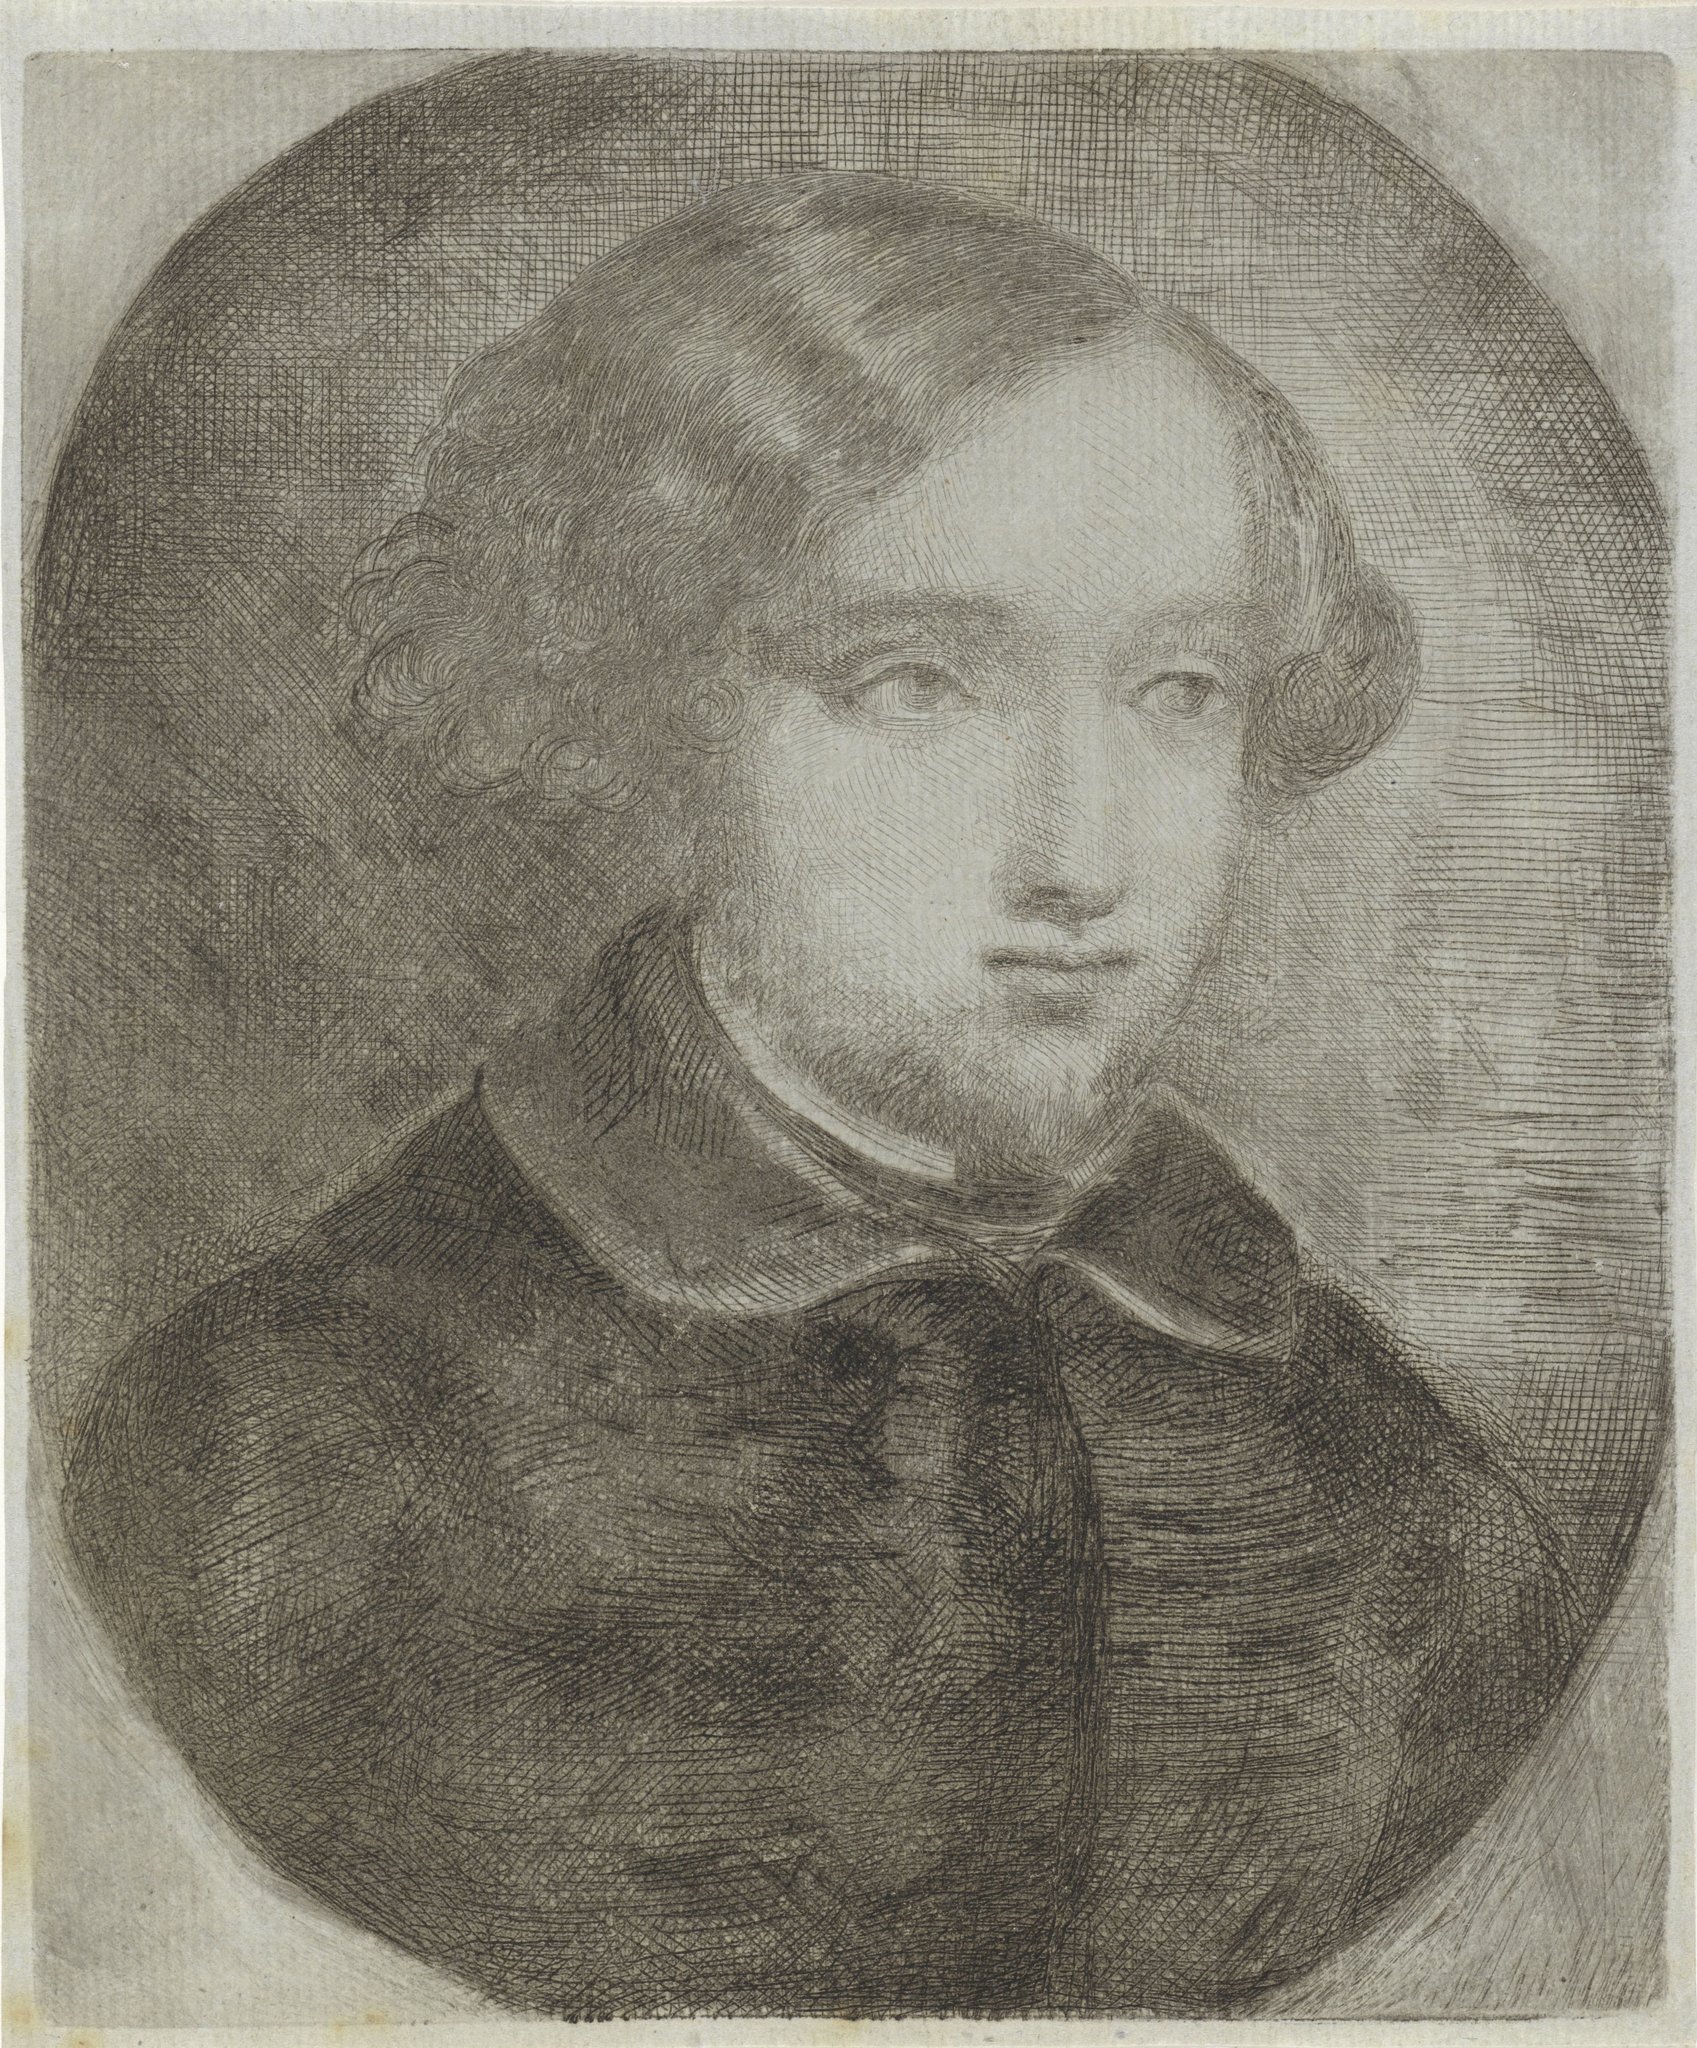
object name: print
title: Busteportret van een jonge man met een puntbaardje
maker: arnoud schaepkens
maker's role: print maker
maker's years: 1816-1904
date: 1831-1904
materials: paper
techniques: drypoint, etching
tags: chest, bust, beard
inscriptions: collector's mark: Lugt 2228, collector's mark: Lugt 1485